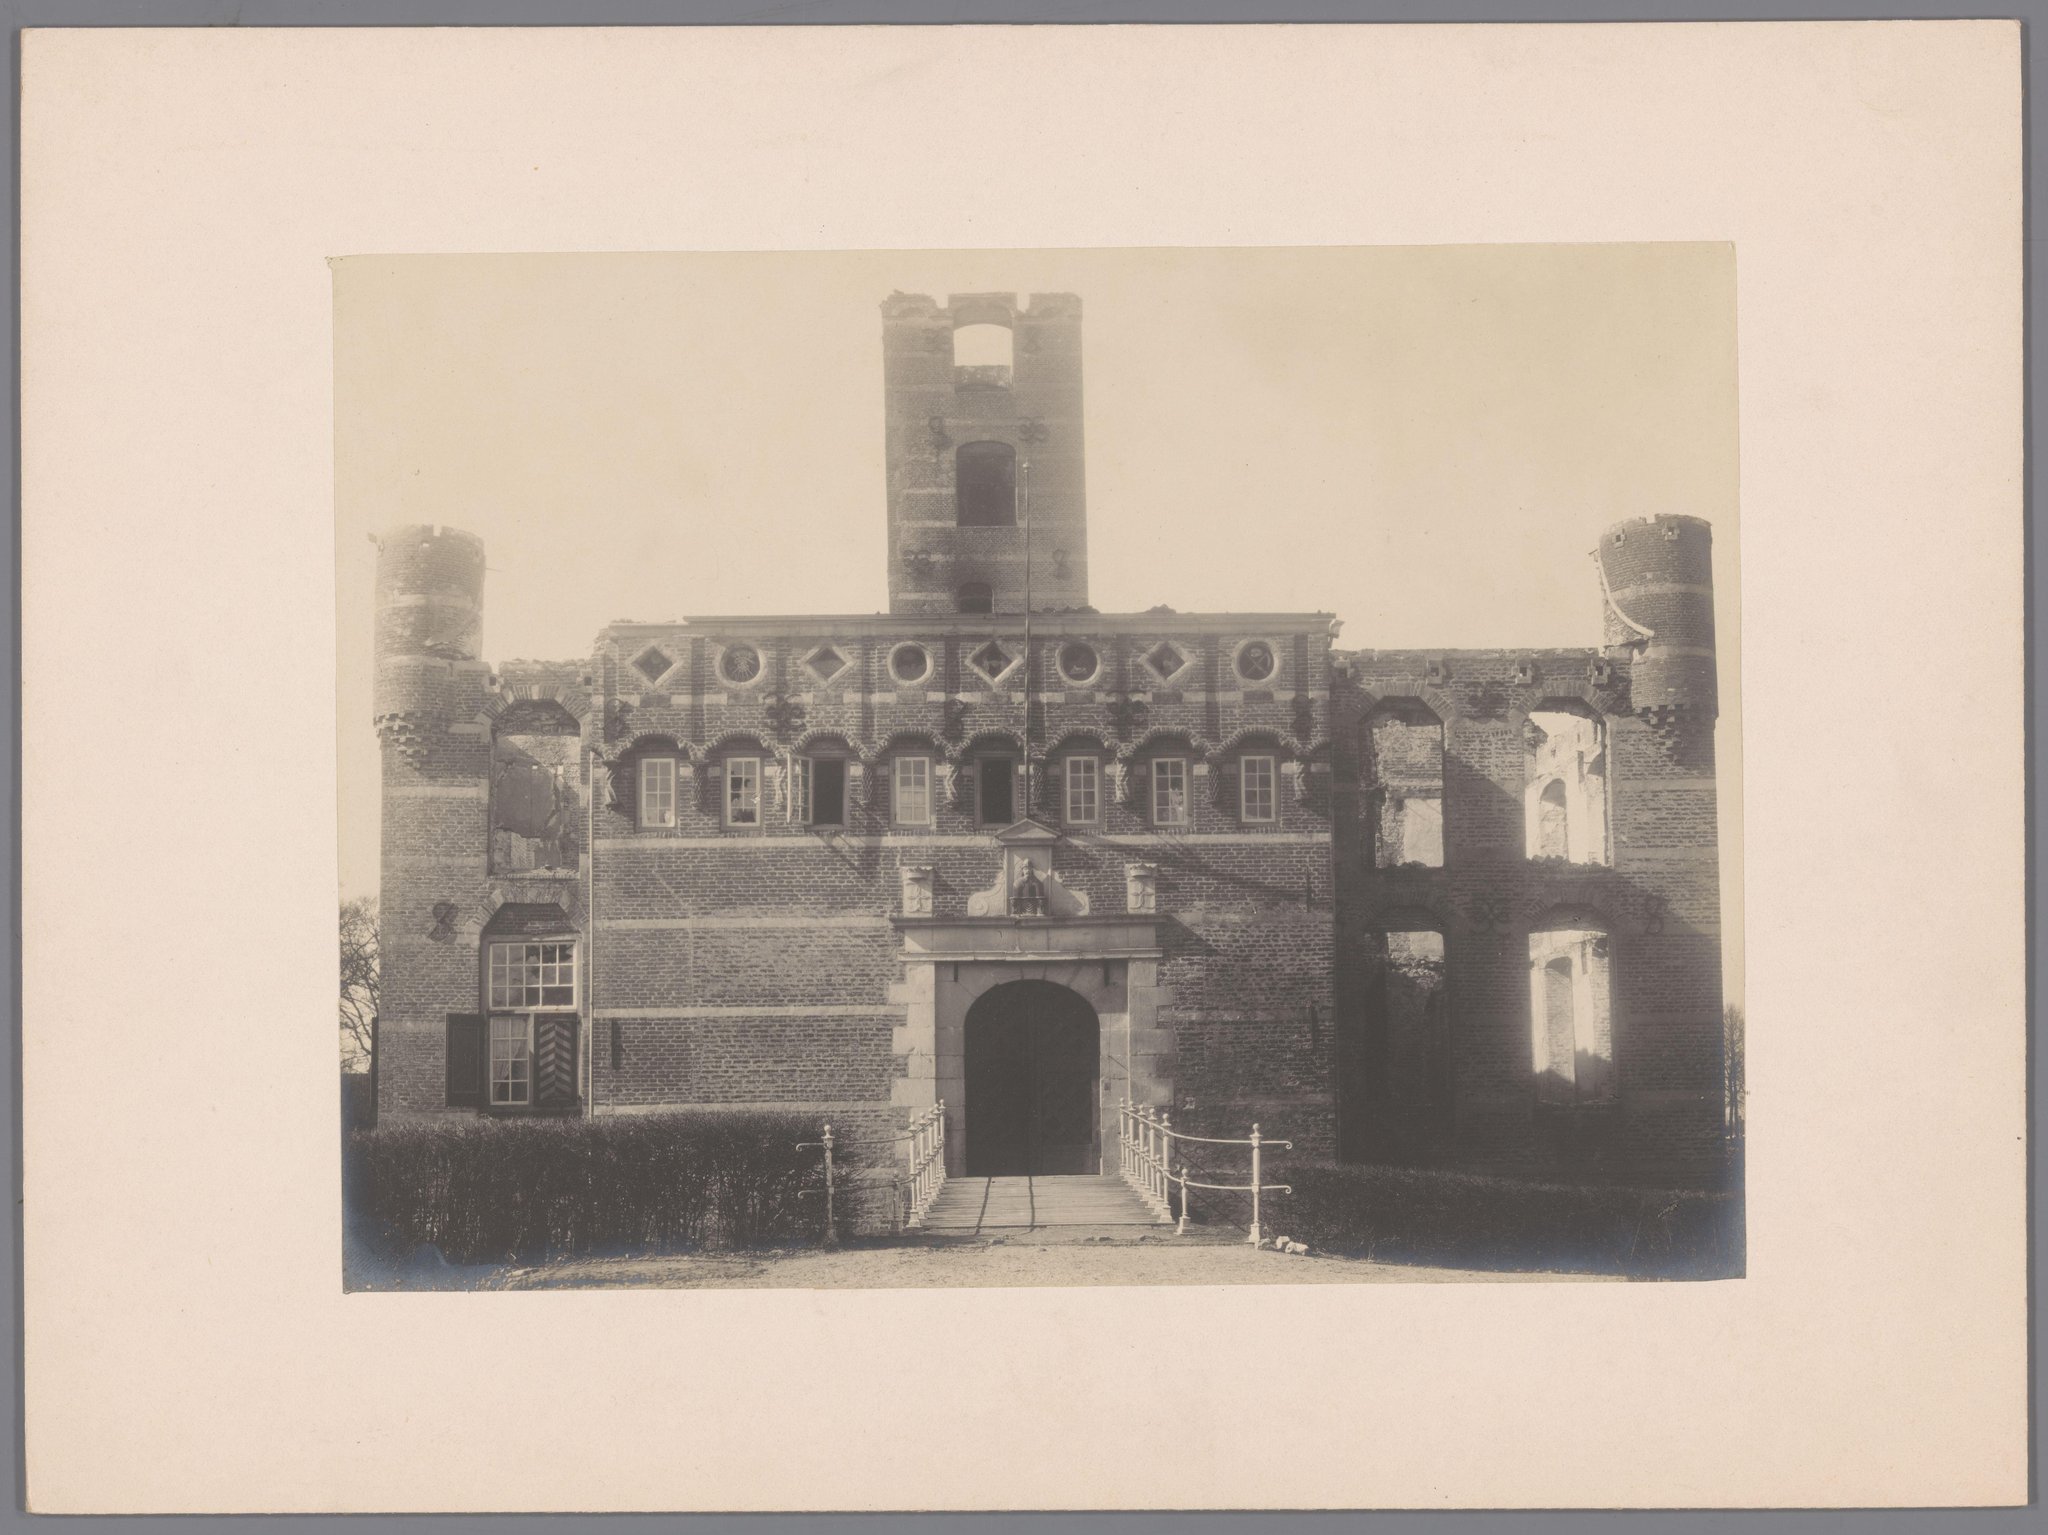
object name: photograph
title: Poort van het Kasteel van Wijchen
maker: anoniem (monumentenzorg)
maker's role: fotograaf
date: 1907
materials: cardboard, photographic support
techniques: gelatin silver print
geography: wijchen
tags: castle, gate, entrance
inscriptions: annotation: ‘Kasteel te Wijchen Voorpoort (G.)/ afgebrand Dec. 1906/ gephoto. Feb 1907’